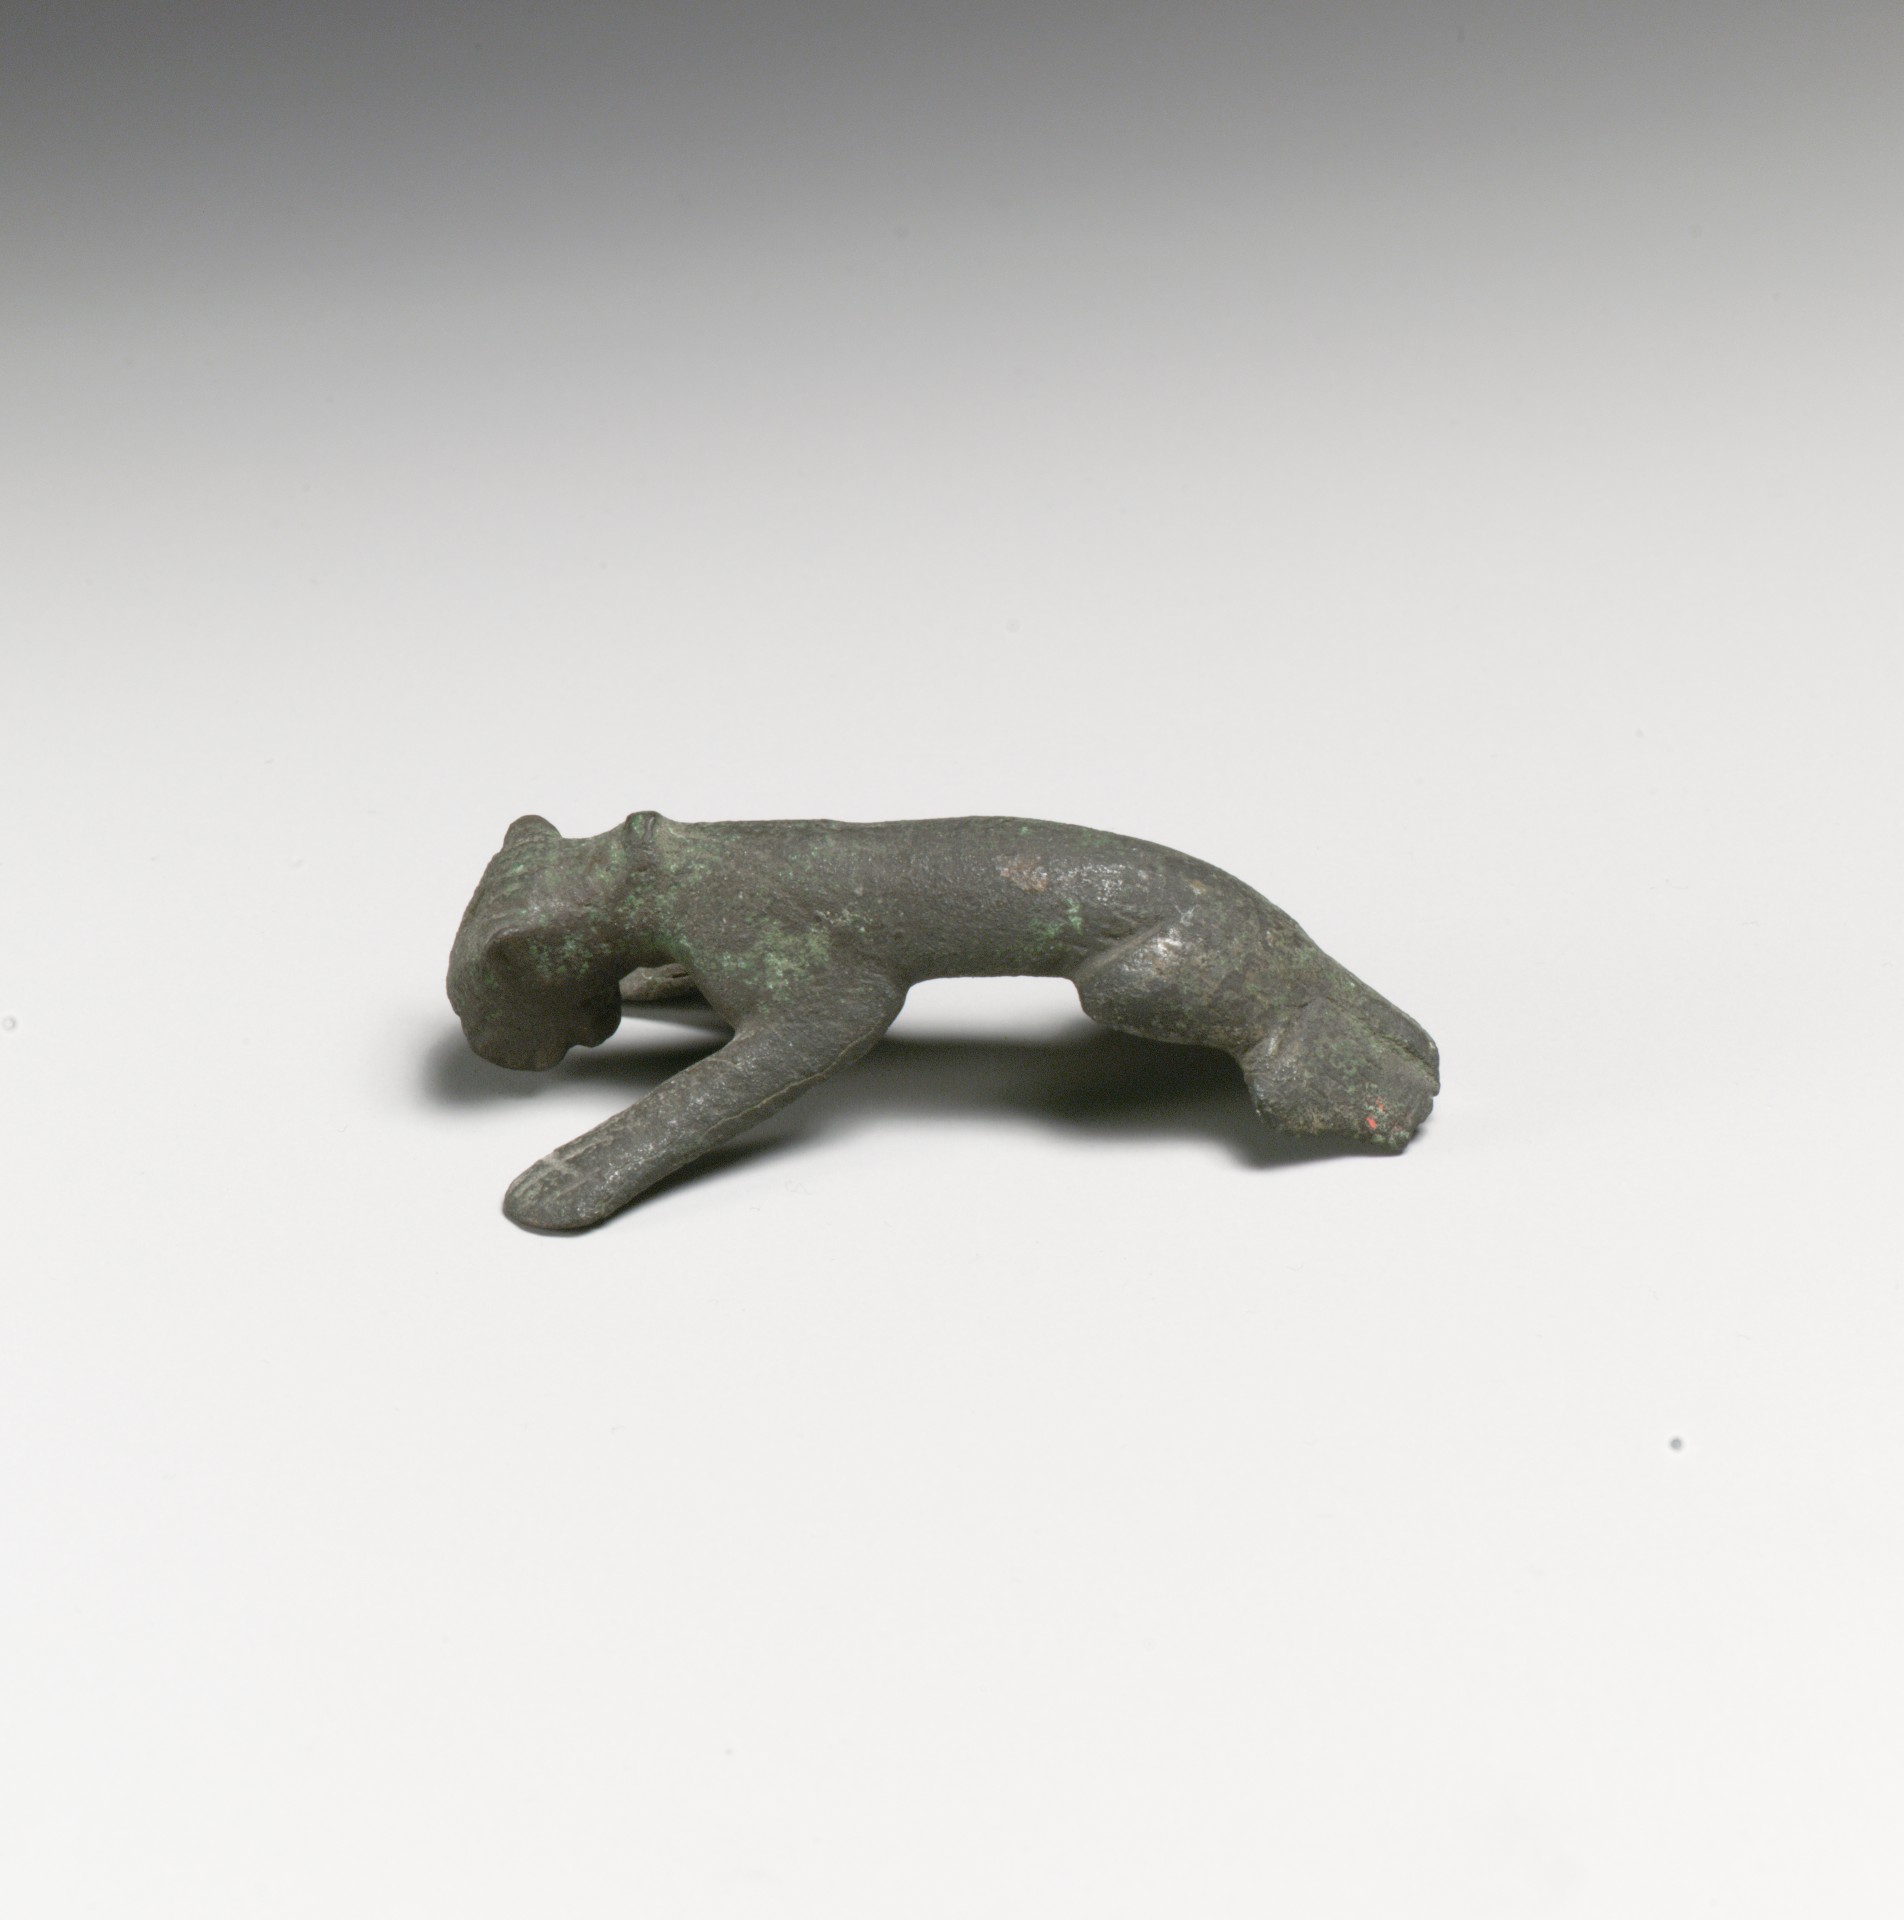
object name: handle in the form of a panther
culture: egyptian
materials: bronze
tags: animals